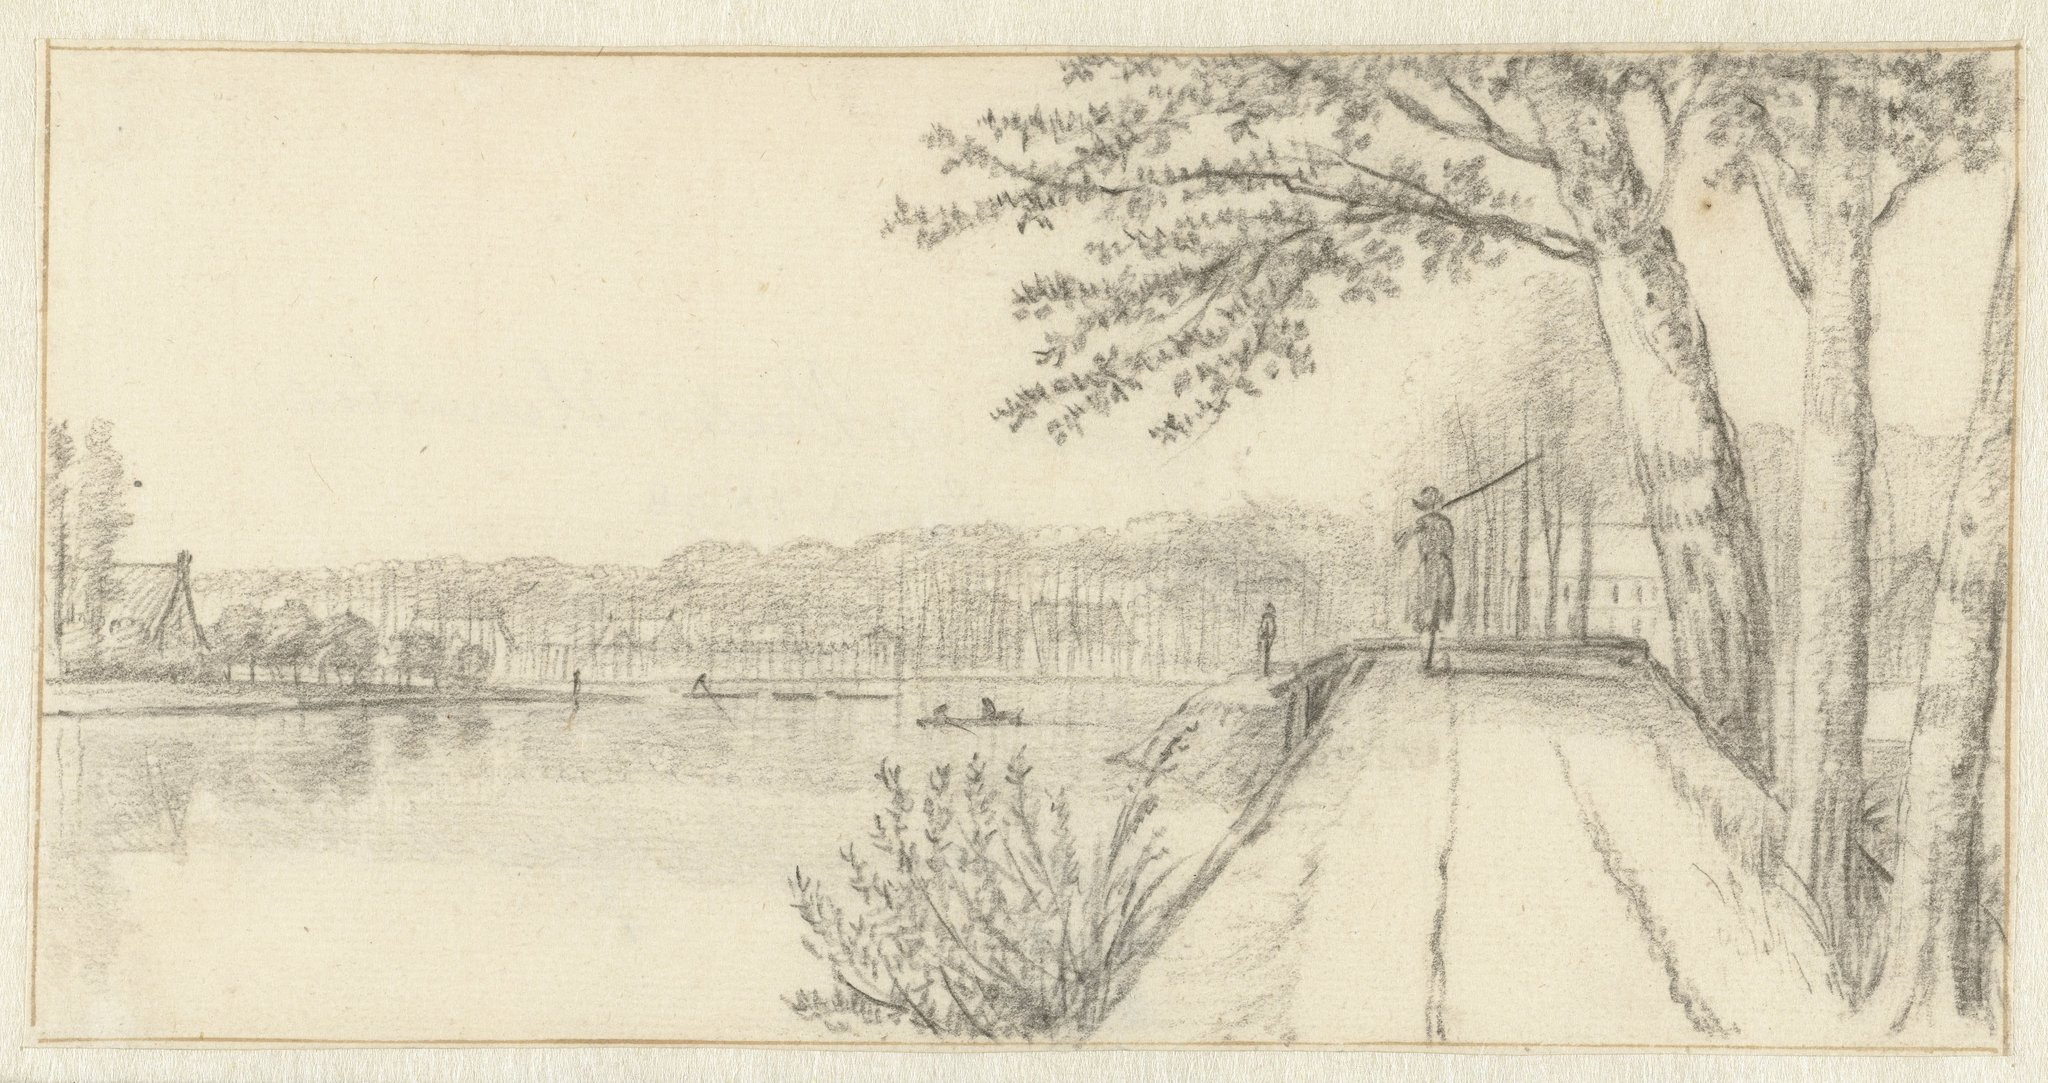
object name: drawing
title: View on the Vecht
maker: abraham rutgers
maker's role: draughtsman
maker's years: 1632-1699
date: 1682-1699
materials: chalk, paper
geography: vecht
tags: river bank, vecht